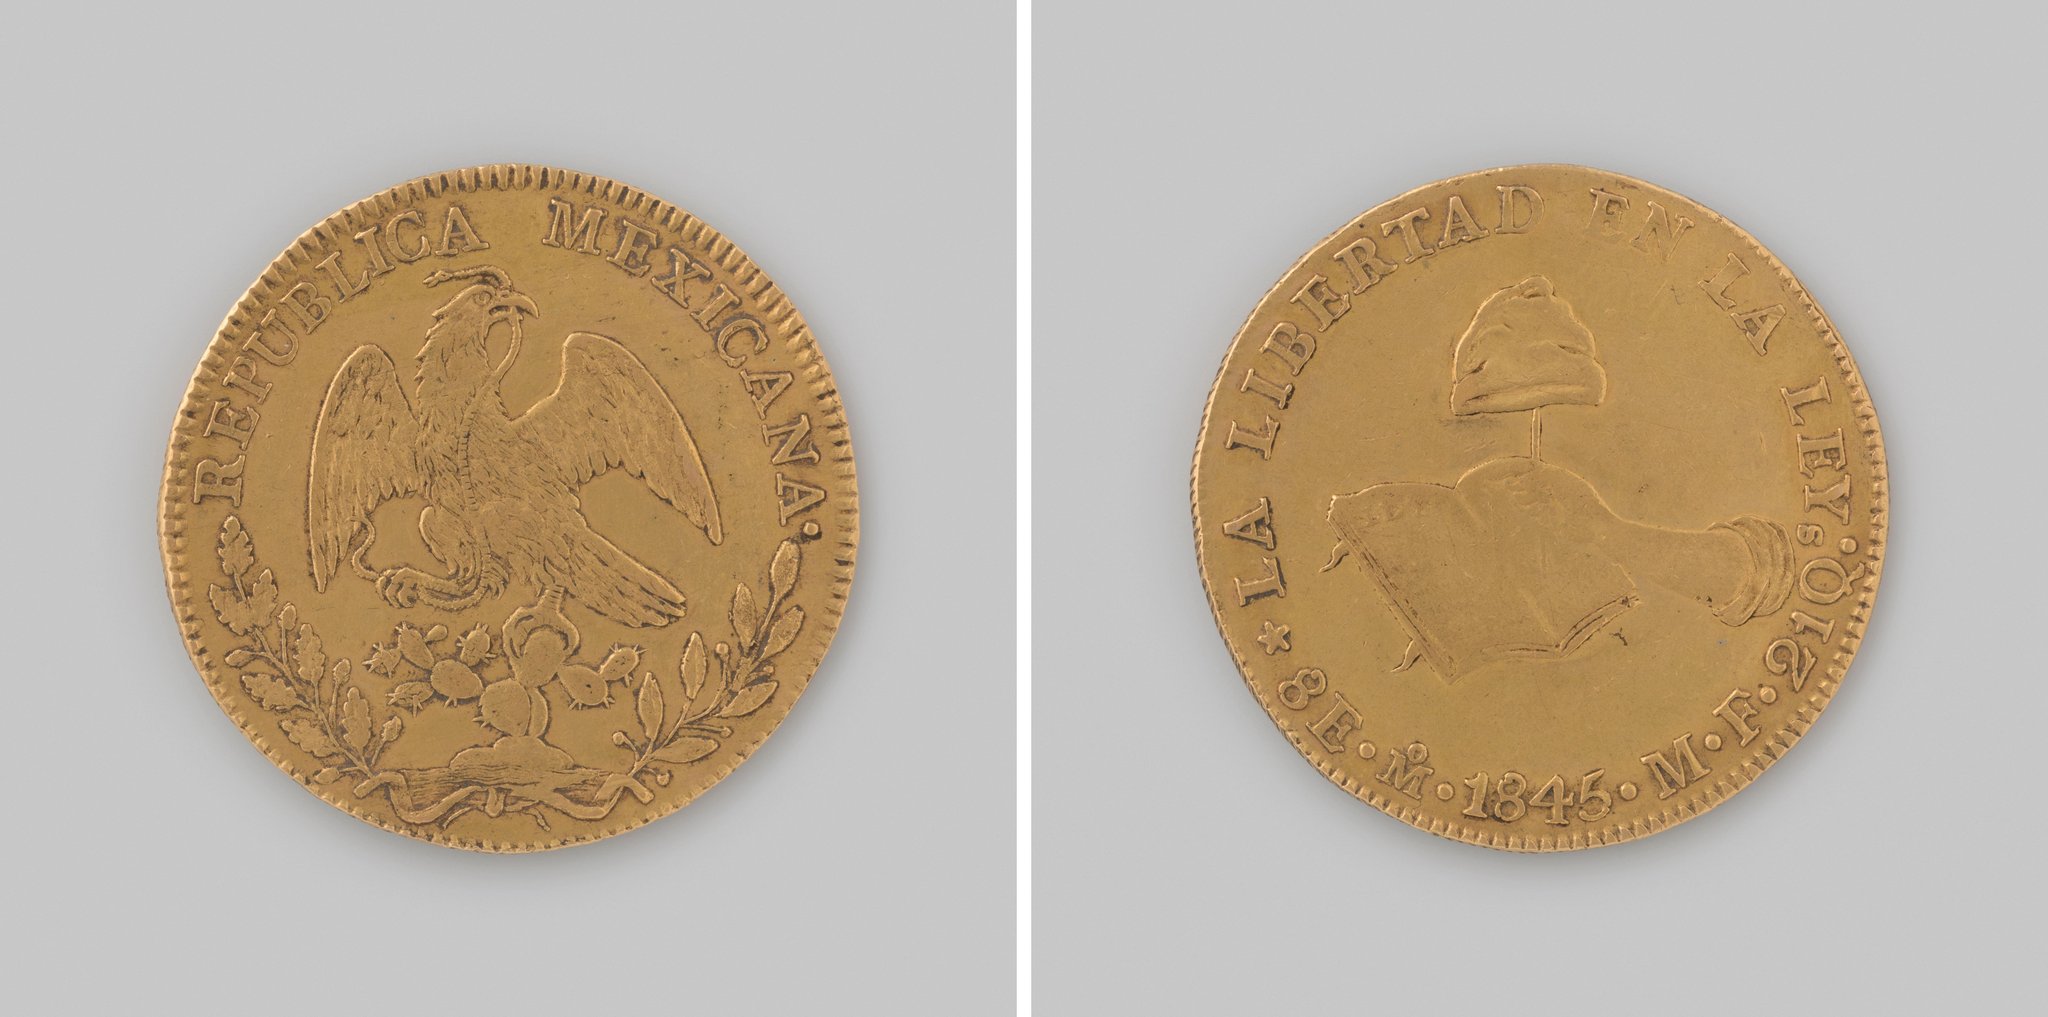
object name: onza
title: Onza of acht escudo uit Mexico, 1845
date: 1845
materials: gold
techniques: striking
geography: mexico city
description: Gouden munt. Voorzijde: tussen twee samengebonden takken op cactusplant staande adelaar met gespreide vleugels met zijn kop naar rechts met in zijn bek een slang. Keerzijde: opengeslagen wetboek met daarboven van rechts komende uitgestoken arm met hand, waarin pijl waarop vrijheidshoed. In omschrift muntplaats-aanduiding: Mo. en waarde-aanduiding: 8E met onderaan jaartal. Kabelrand.